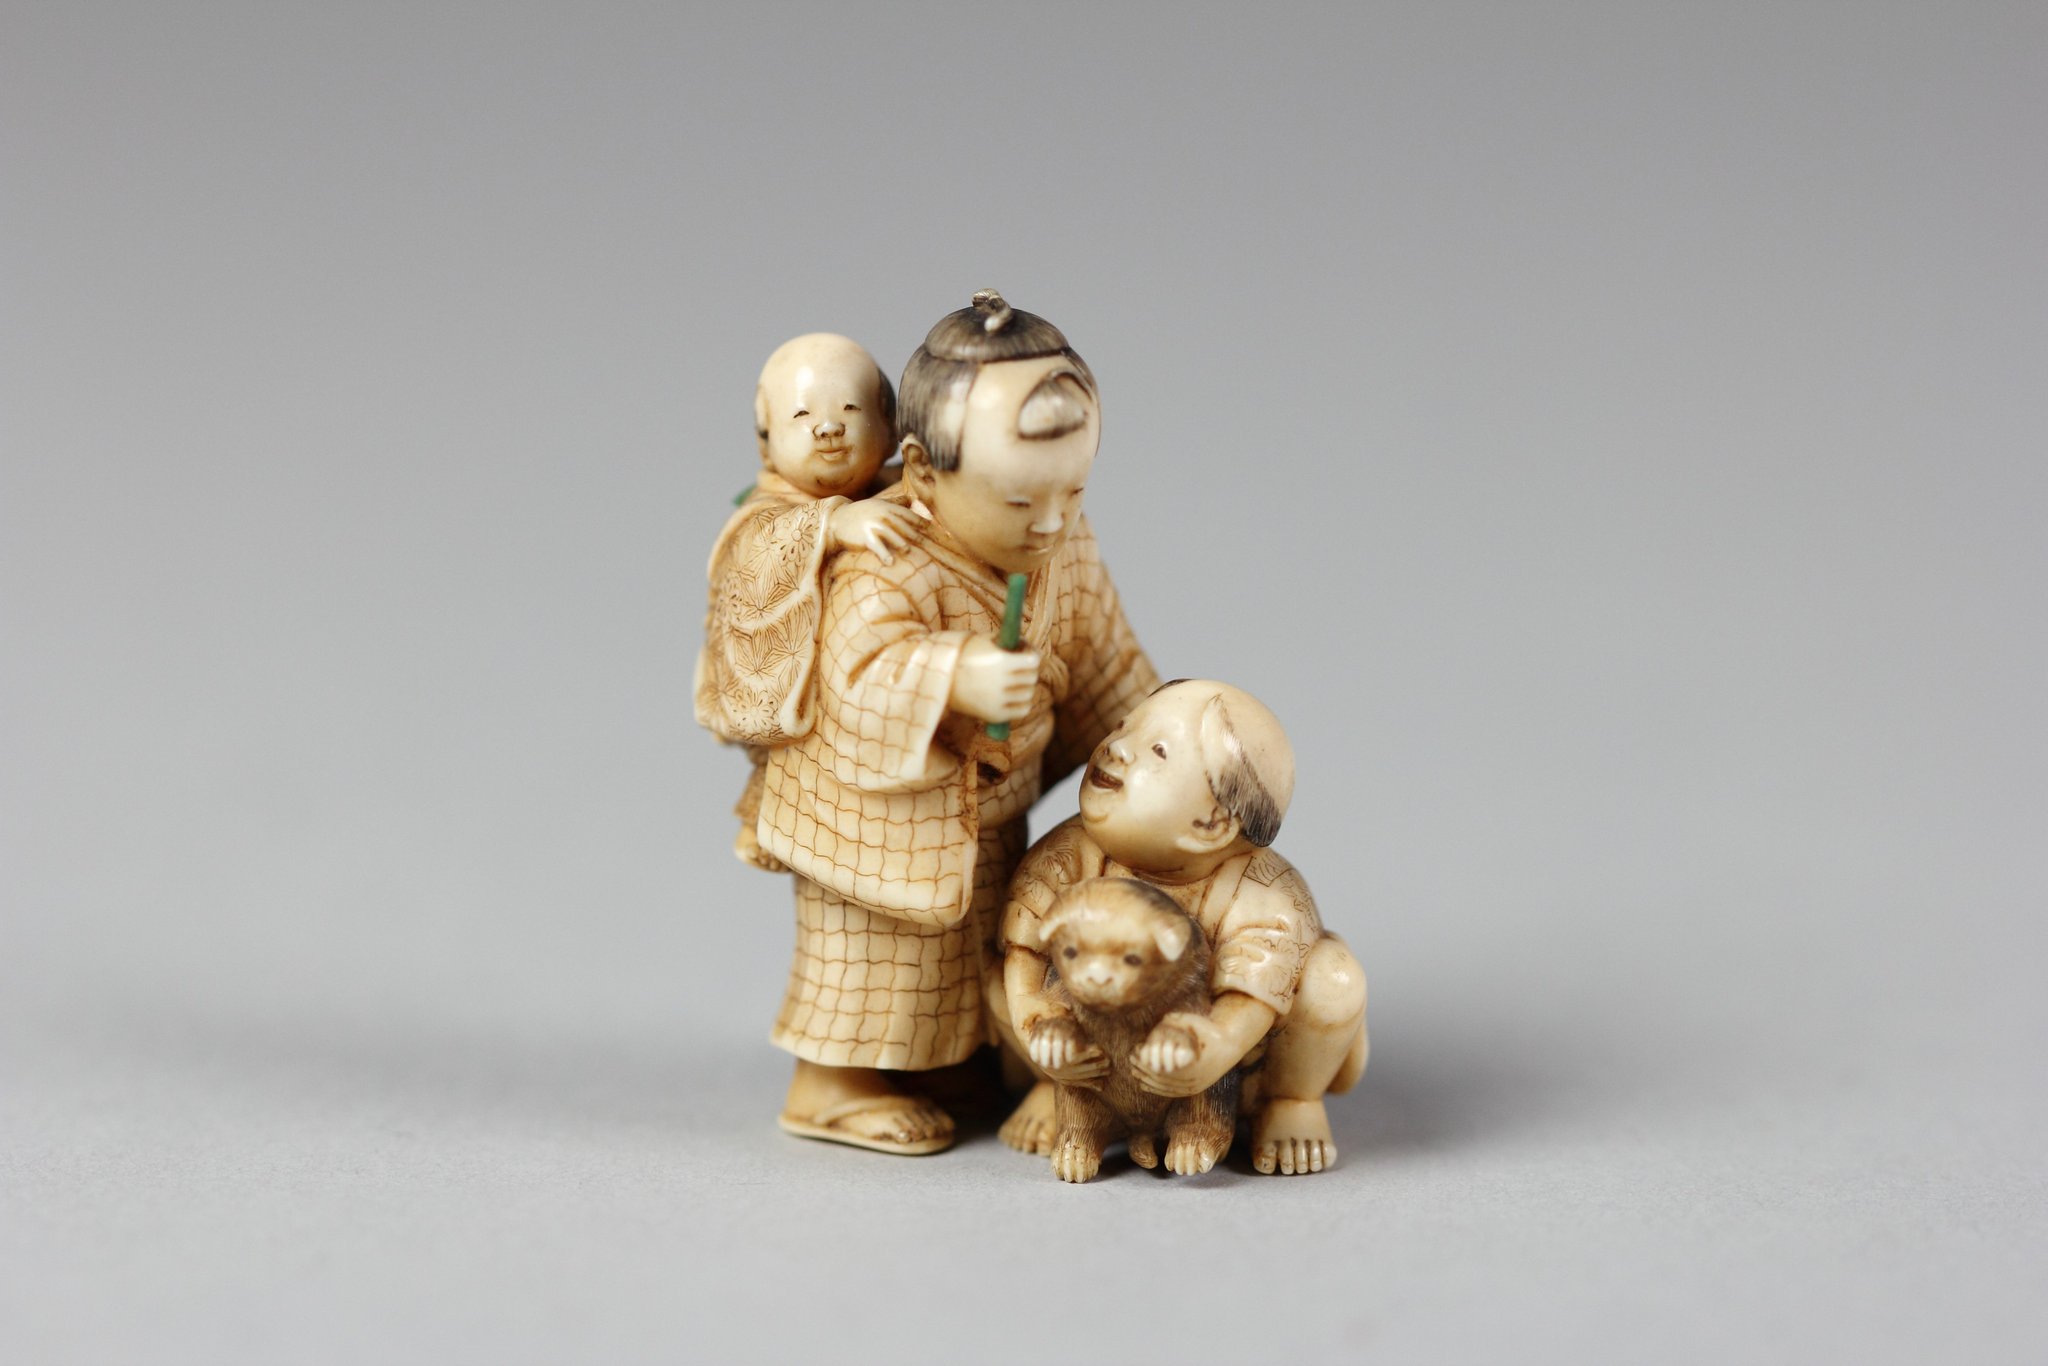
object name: netsuke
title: Children with Puppy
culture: japanese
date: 1801-1900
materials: ivory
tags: children,dogs